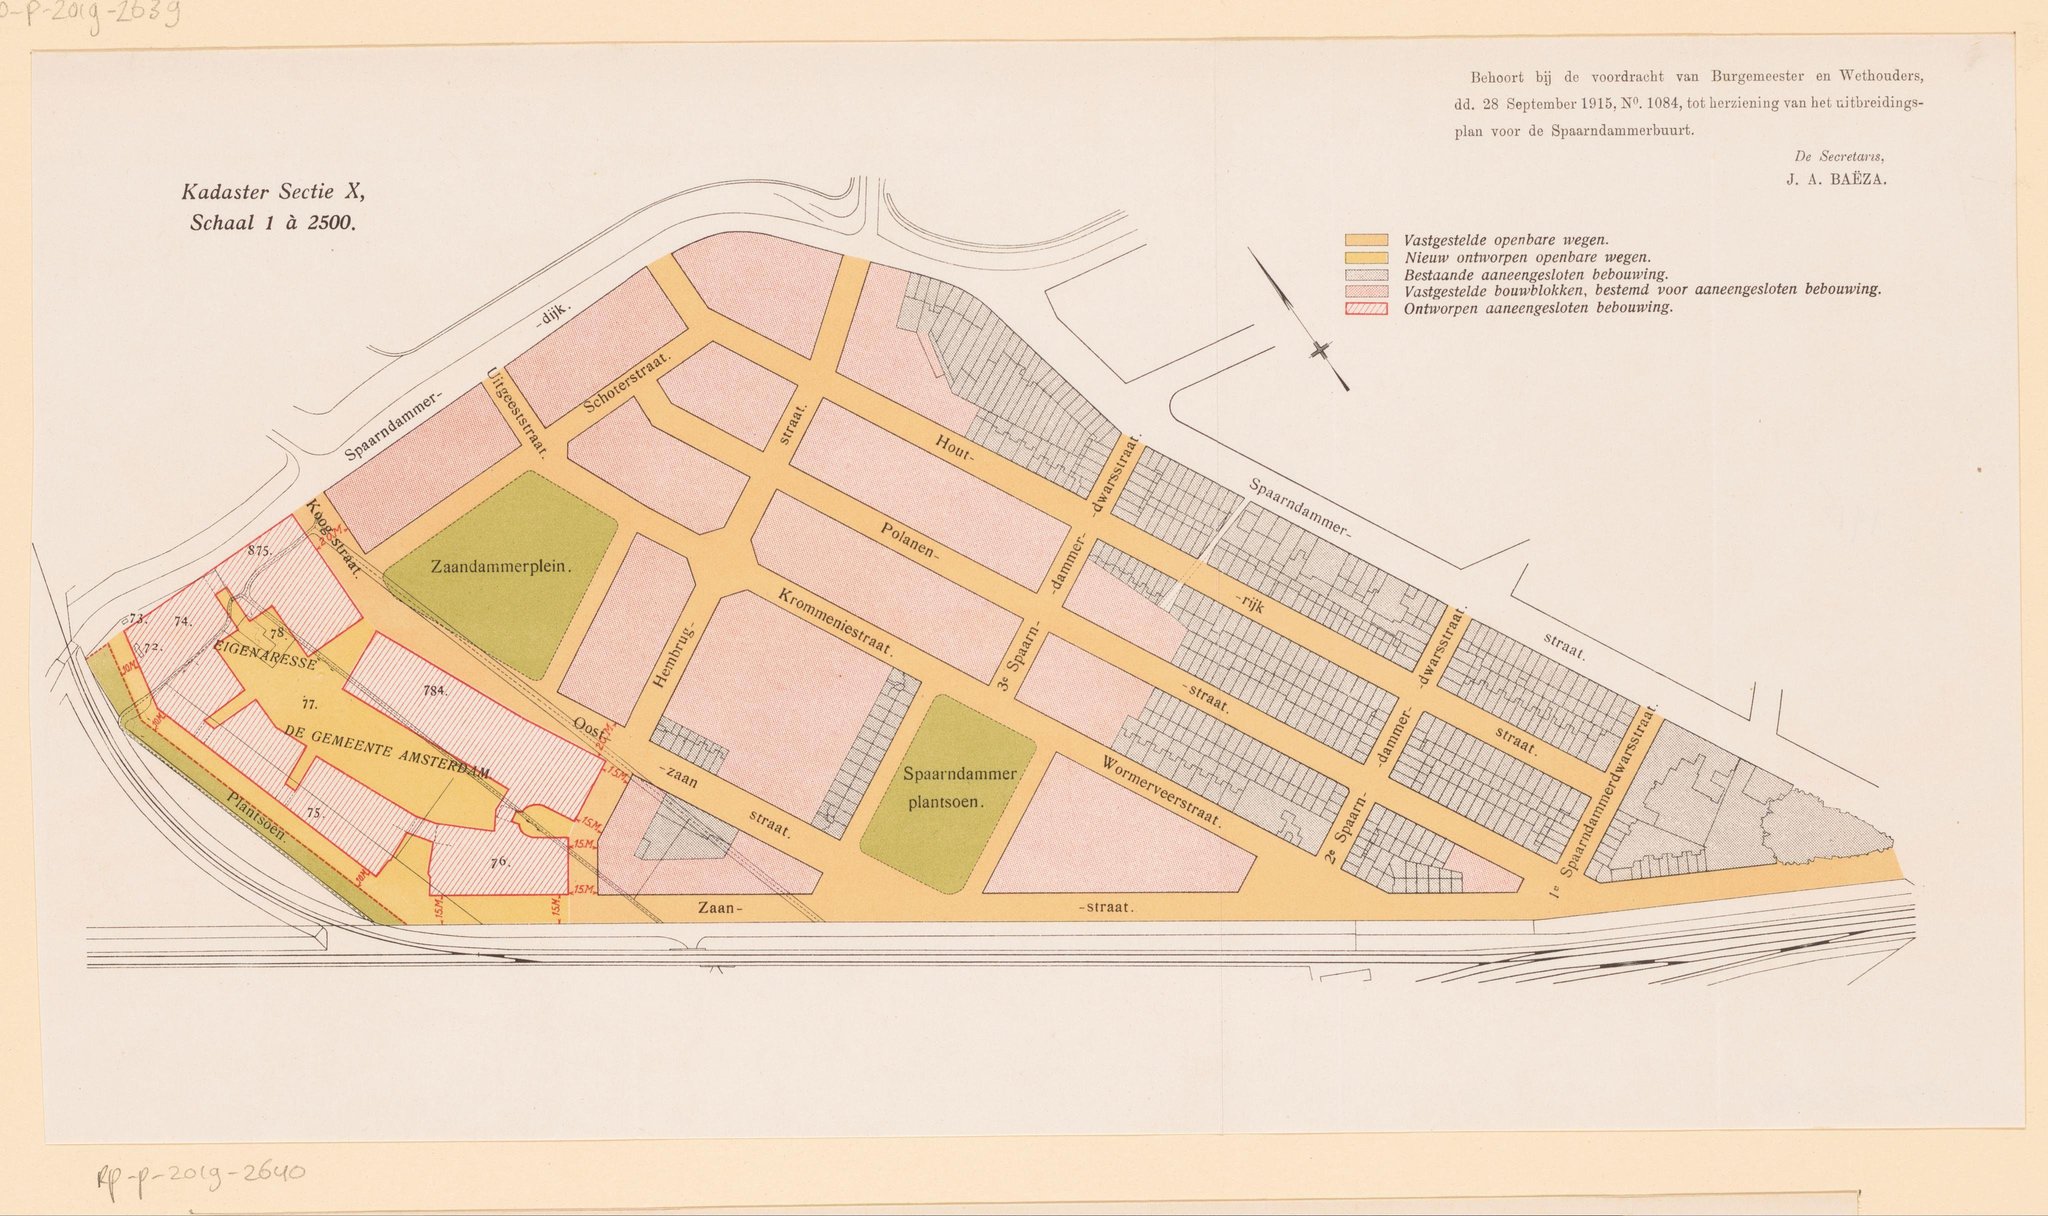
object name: area plan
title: Reproductie van een plattegrond van een deel van de Spaarndammerbuurt te Amsterdam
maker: Anonymous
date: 1915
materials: paper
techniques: offset printed, photolithography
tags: maps of cities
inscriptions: date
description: Rechtsboven: Behoort bij de voordracht van burgemeester en wethouders, dd. 28 September 1915 (...) tot herziening van het uitbreidingsplan voor de Spaarndammerbuurt.